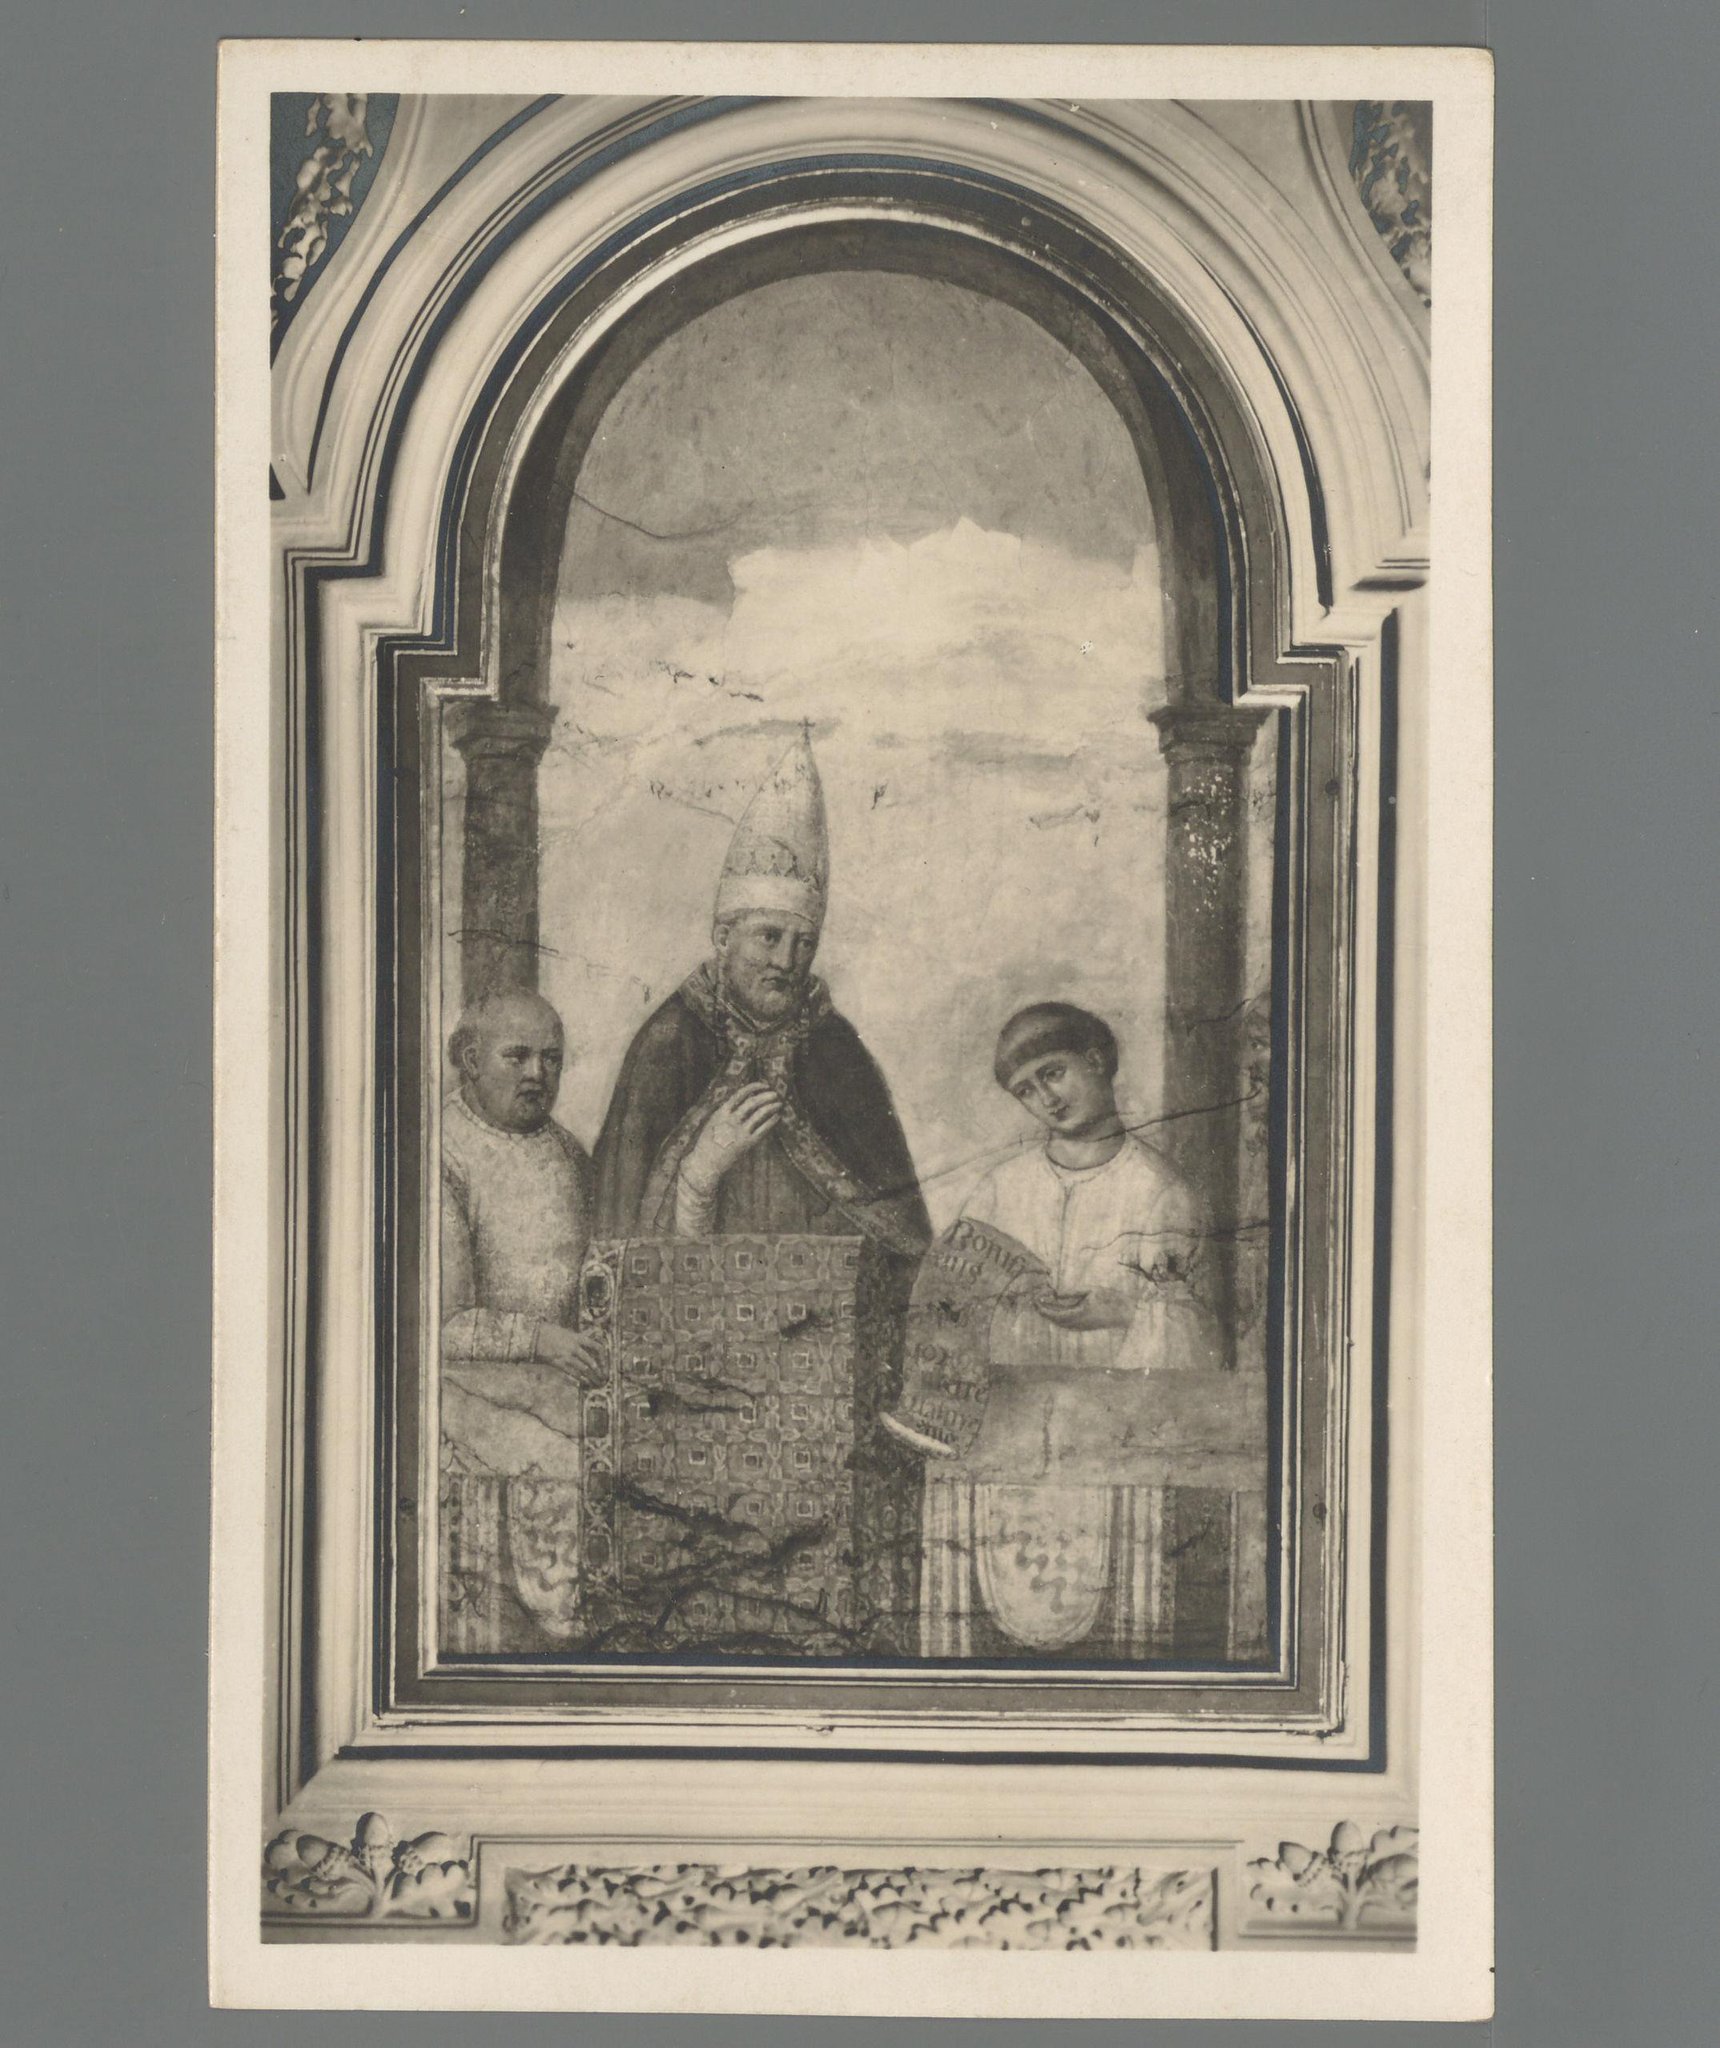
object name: photograph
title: Roma - Basilica di S. Giovanni in Laterano. Bonifacio VIIIo proclama il Giubileo (Giotto?)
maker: Anonymous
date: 1906-1930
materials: paper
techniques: gelatin silver print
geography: rome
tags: interior of church, picture, painting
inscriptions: collector's mark: ‘AFE v S’